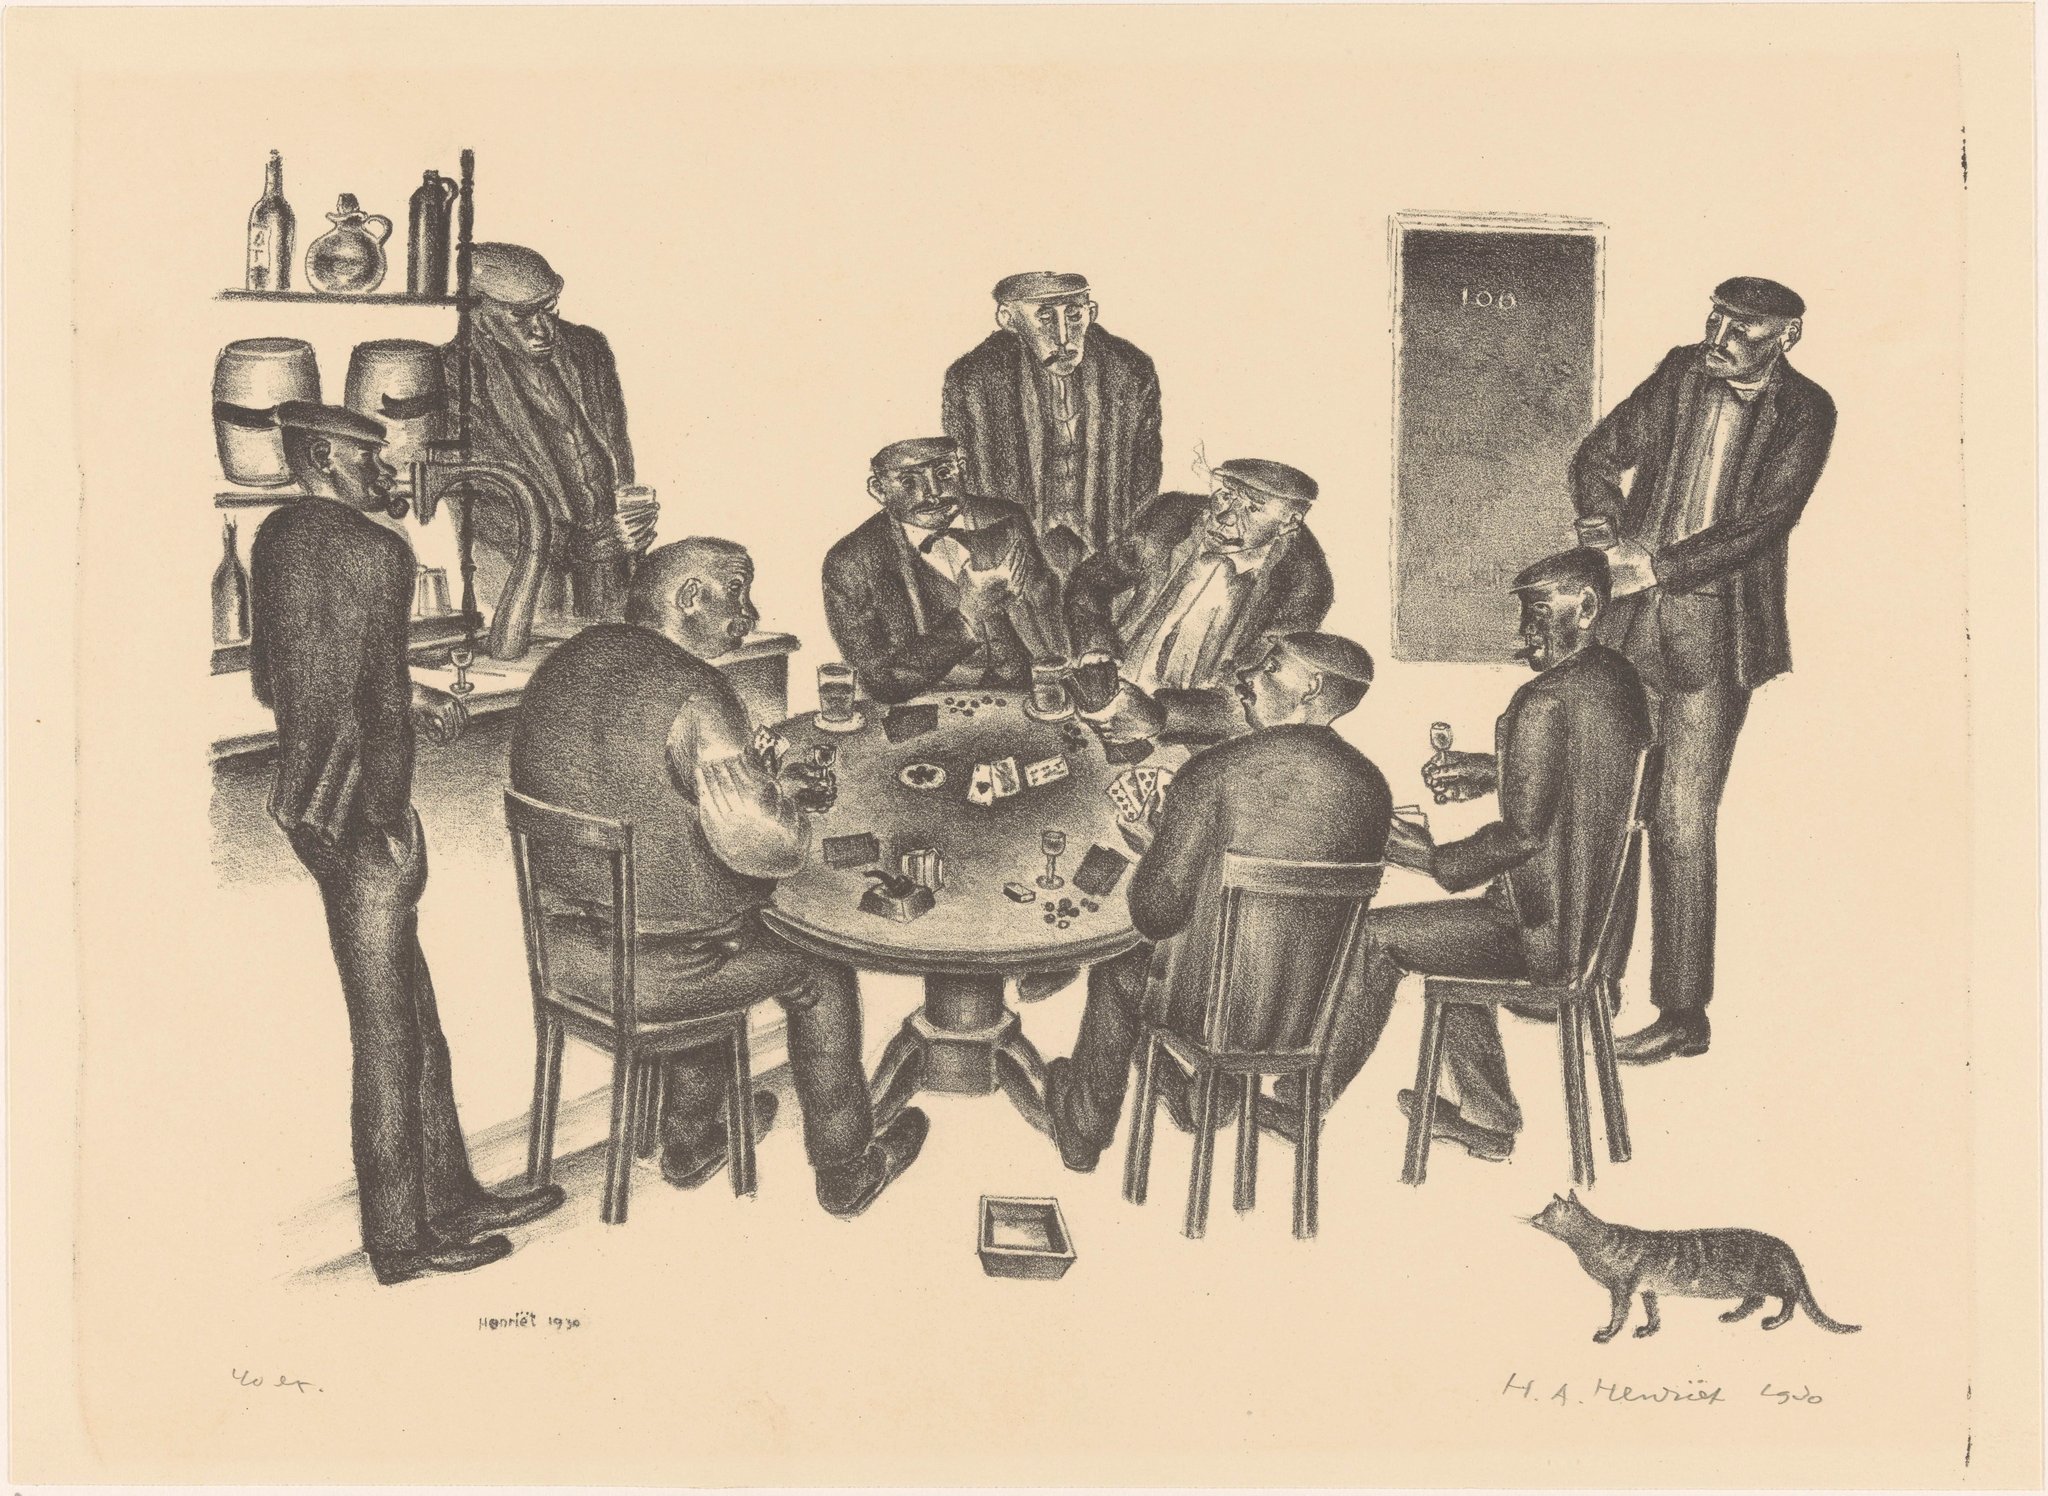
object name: print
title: Kaartspelende mannen in een bar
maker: henk henriët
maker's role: draughtsman, print maker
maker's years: 1903-1945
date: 1930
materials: paper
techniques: lithograph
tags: cat, inn, coffee-house, public house, etc., playing-cards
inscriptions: collector's mark: Lugt 2228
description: Sommige mannen roken. Rechts op de voorgrond kijkt een kat toe.